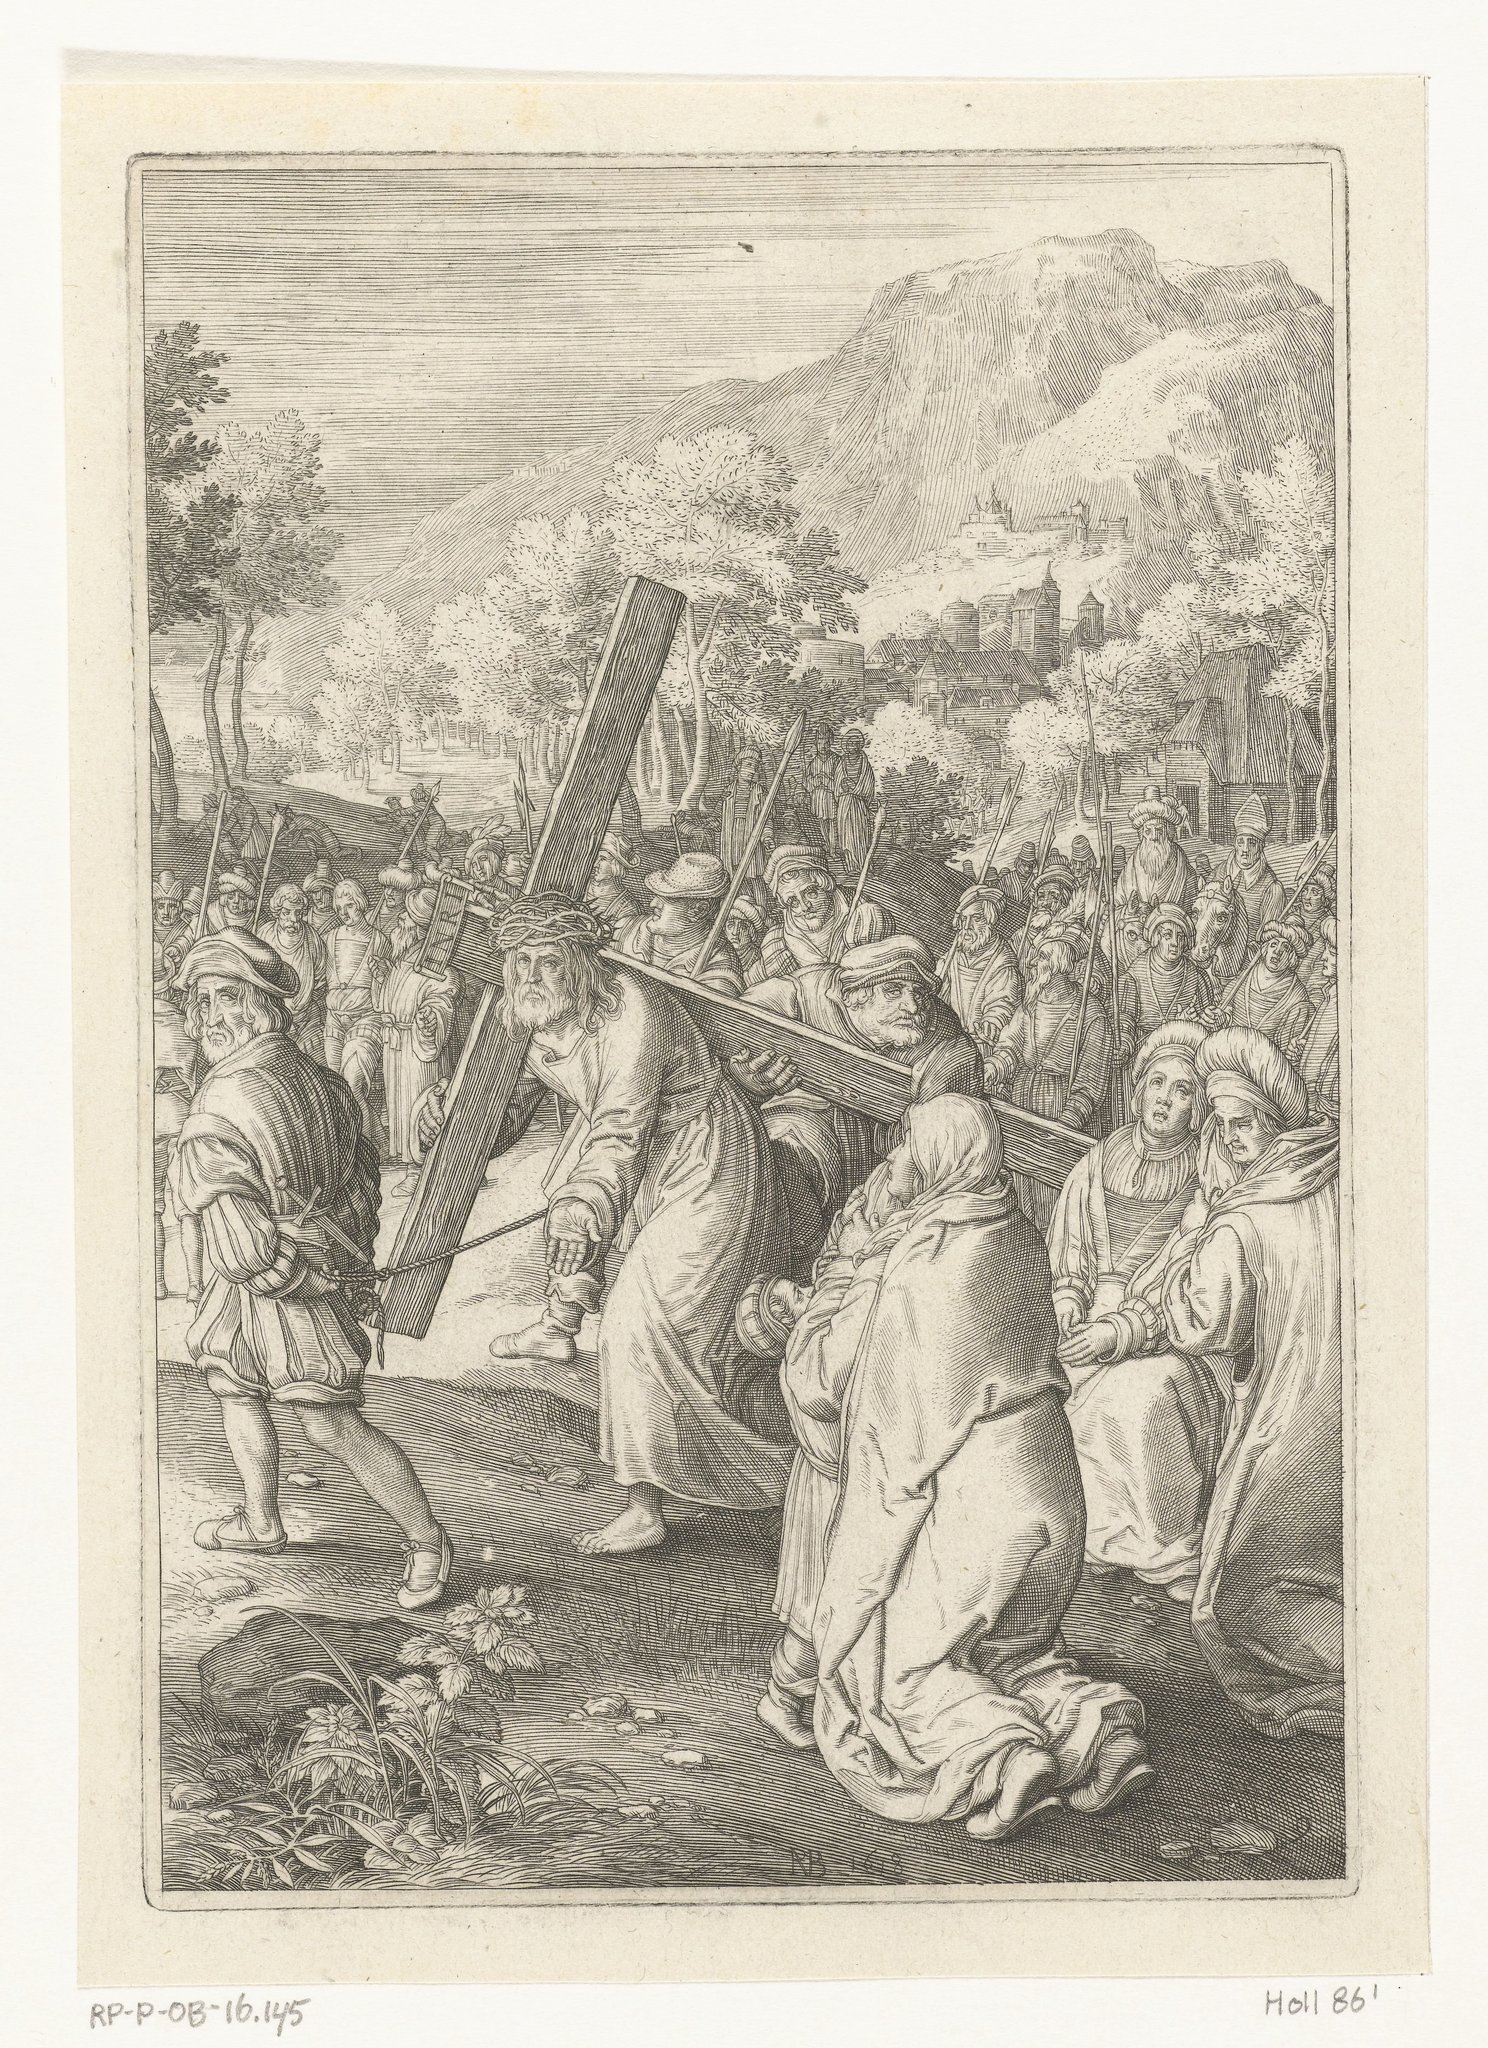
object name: print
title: Kruisdraging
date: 1618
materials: paper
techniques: engraving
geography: netherlands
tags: carrying of the cross: christ bearing the cross, alone or with the help of others (e.g. simon the cyrenian)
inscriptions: collector's mark: Lugt 2228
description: Prent uit serie van twaalf prenten met scènes uit de Passie. Reeks geïnspireerd door de prenten van Hendrick Goltzius en Lucas van Leyden.